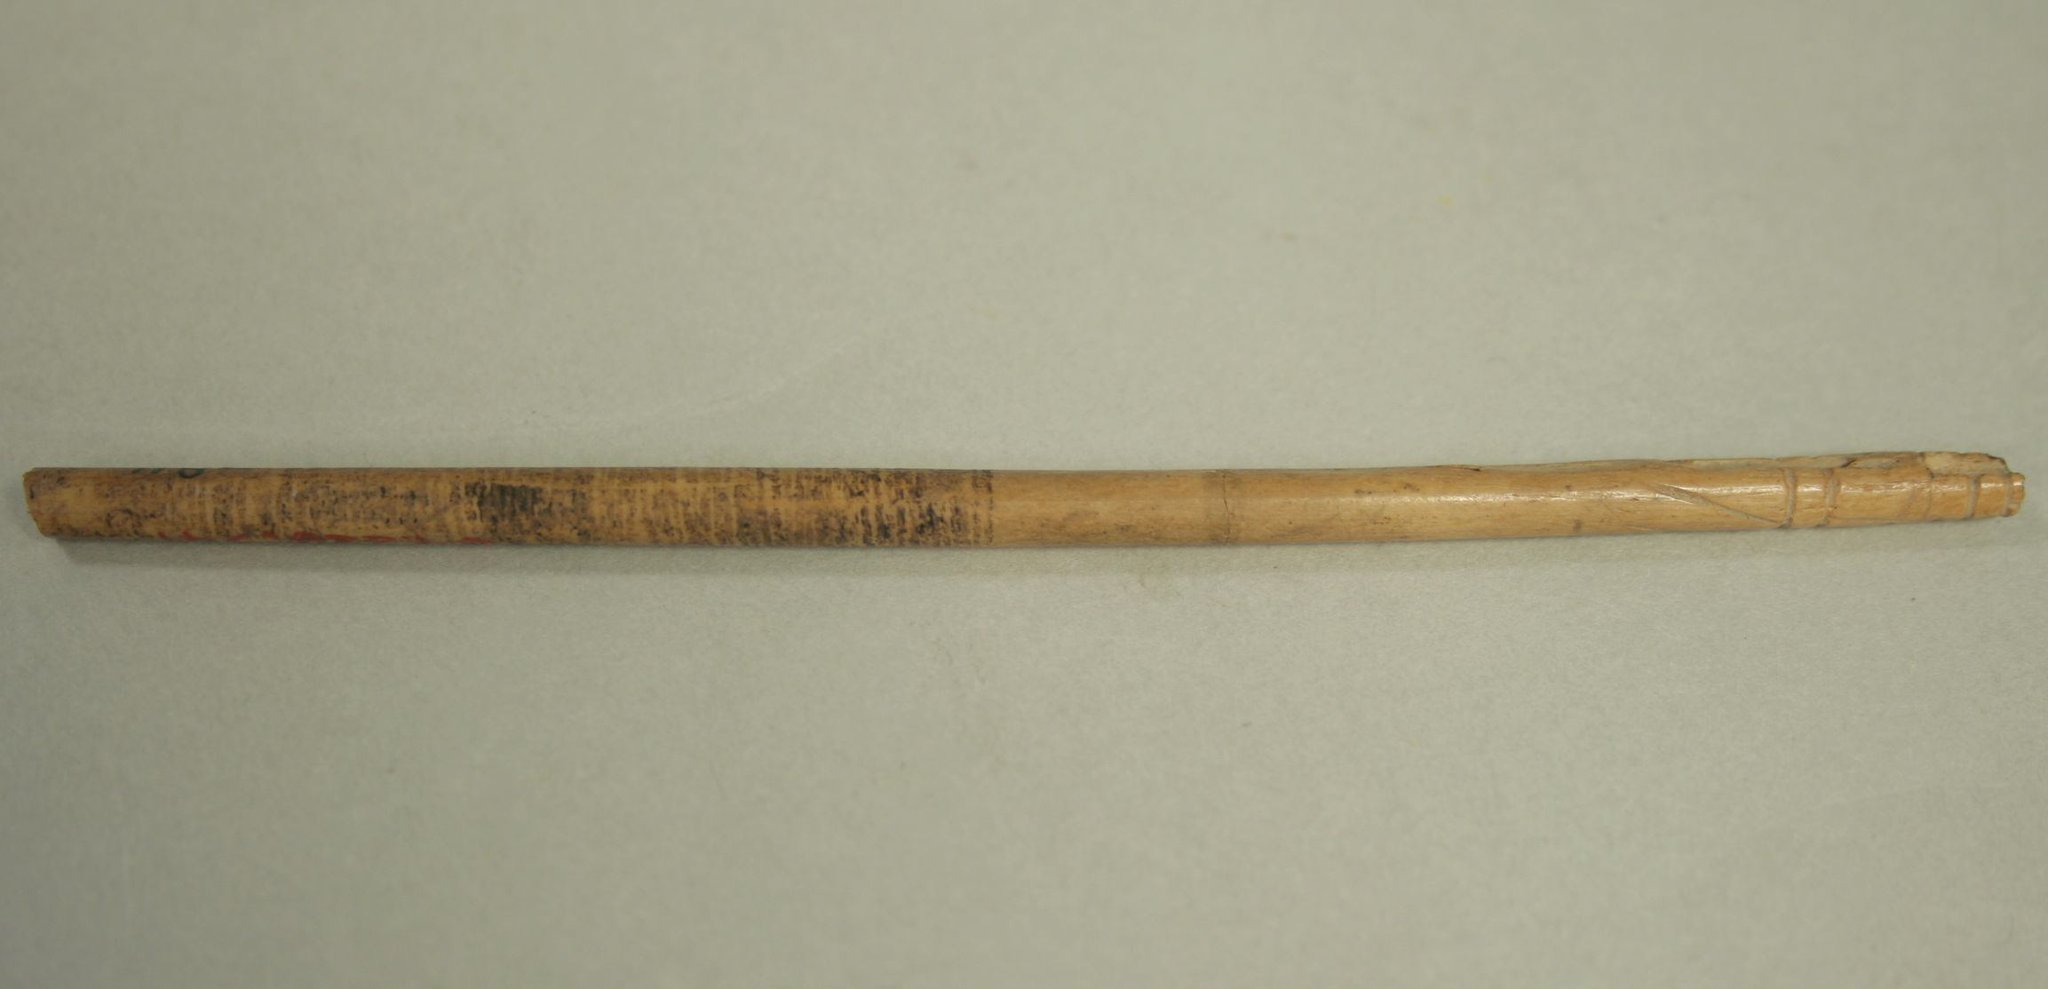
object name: bobbin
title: Bone Weaving Bobbin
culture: peruvian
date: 701-1566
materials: bone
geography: peru